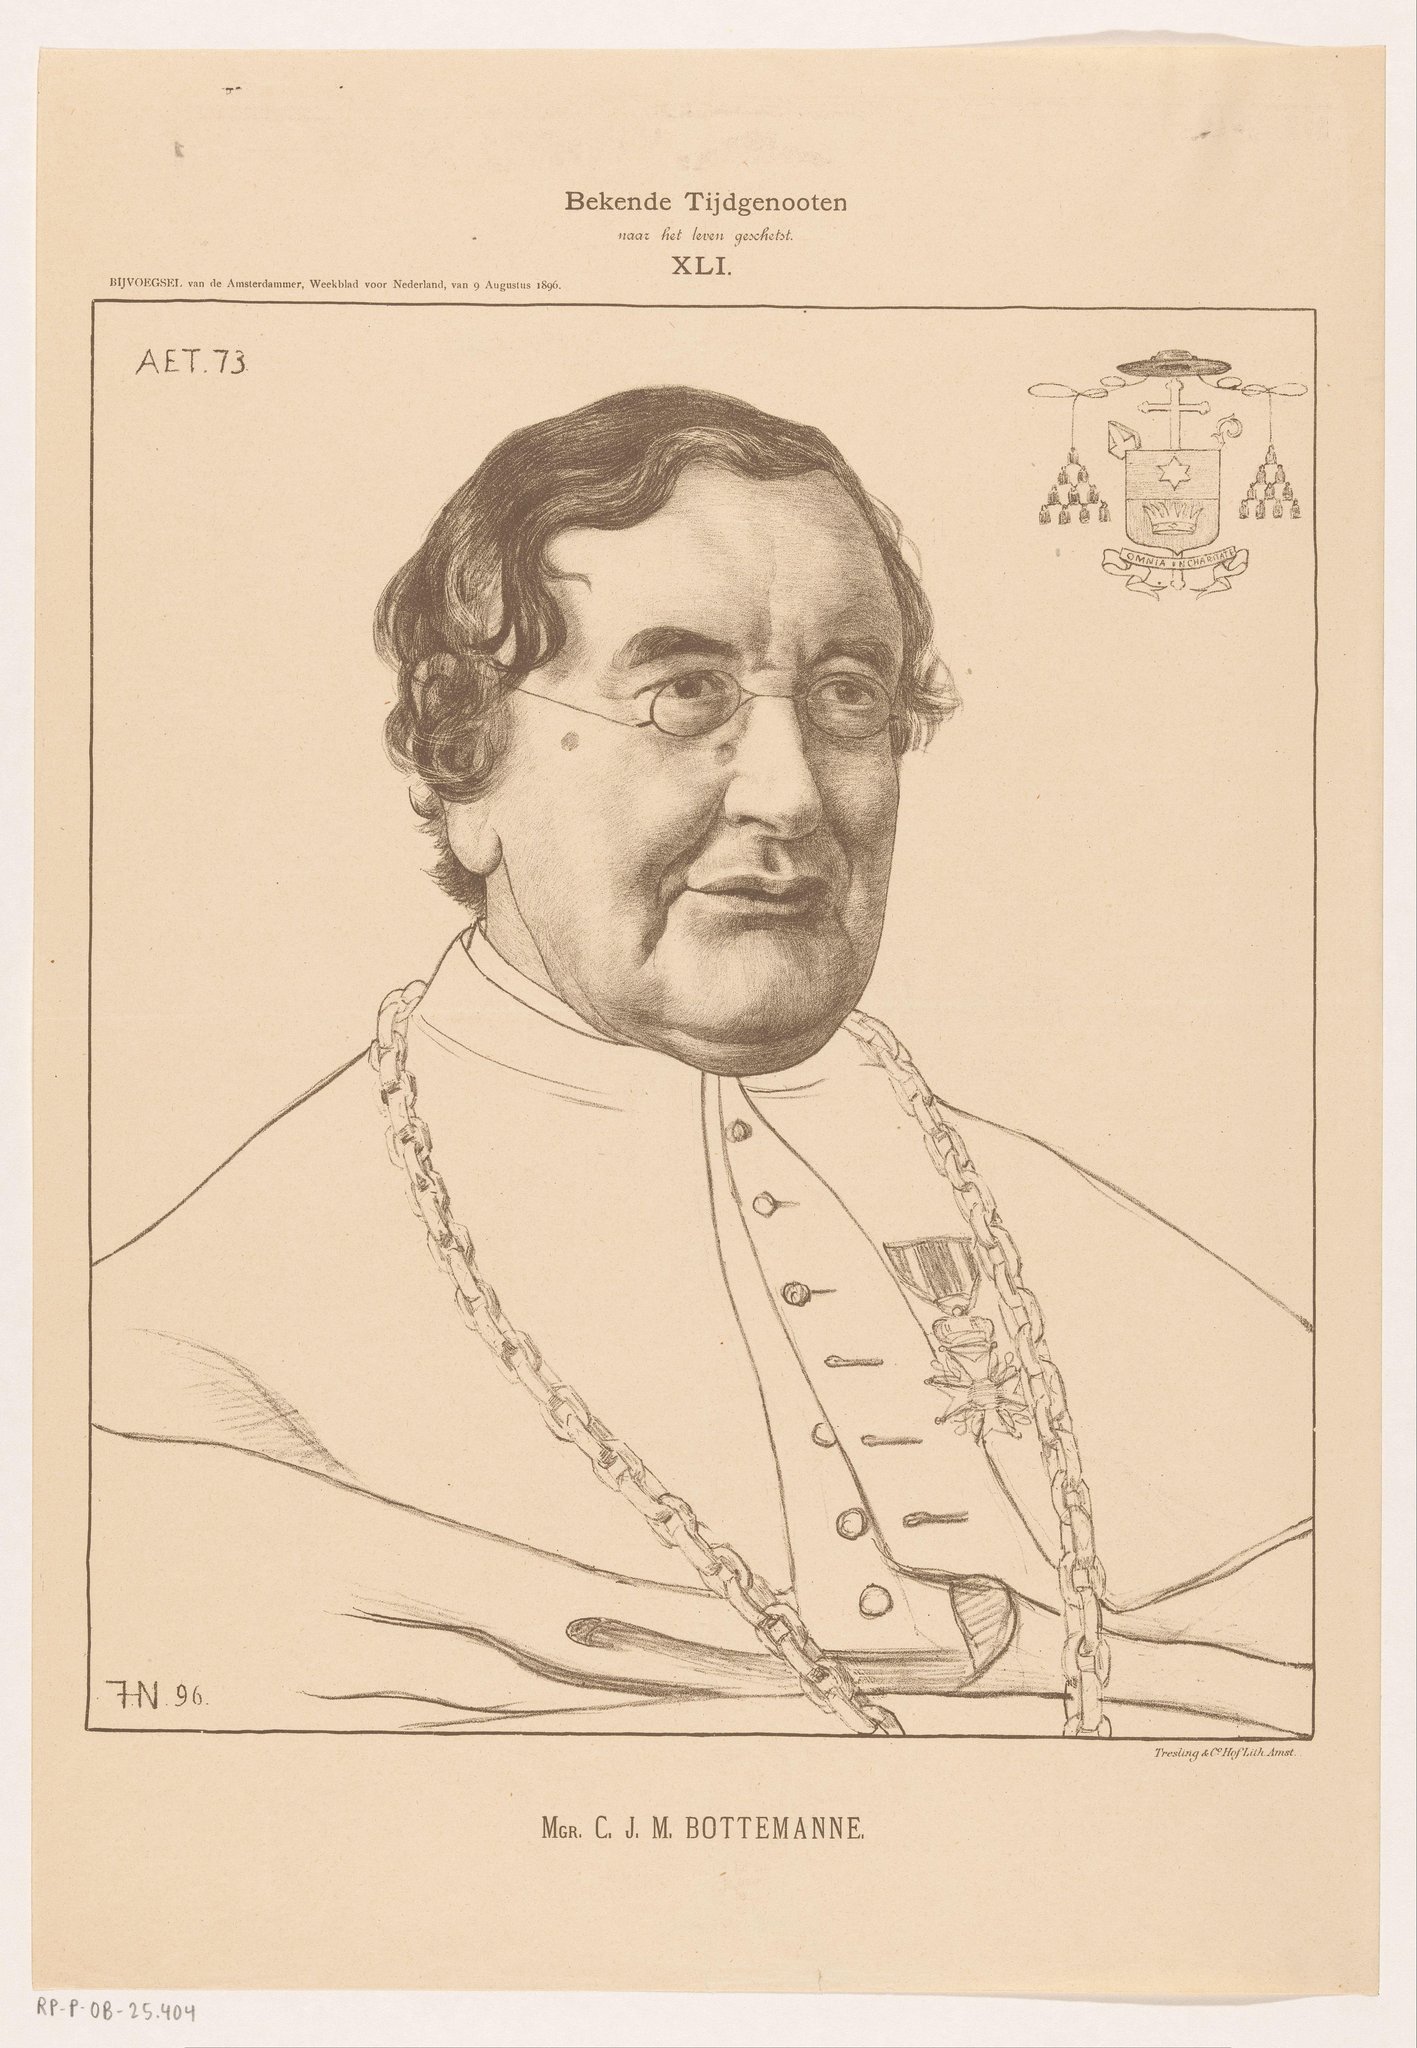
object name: print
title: Bekende tijdgenooten naar het leven geschetst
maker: ferdinand hart nibbrig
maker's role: draughtsman, painter, print maker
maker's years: 1866-1915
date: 1896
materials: paper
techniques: lithograph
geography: amsterdam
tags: haarlem, historical persons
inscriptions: collector's mark: Lugt 2228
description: Een portret van Caspar Josefus Martinus Bottemanne op drieënzeventigjarige leeftijd, de zesde bisschop van het bisdom Haarlem.